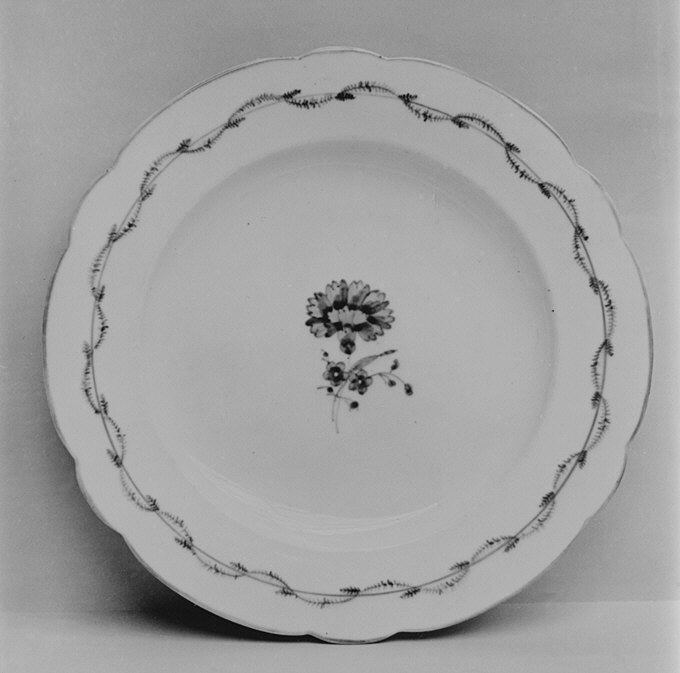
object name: plate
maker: chantilly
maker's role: factory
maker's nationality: french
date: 1770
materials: soft paste porcelain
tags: garlands,flowers